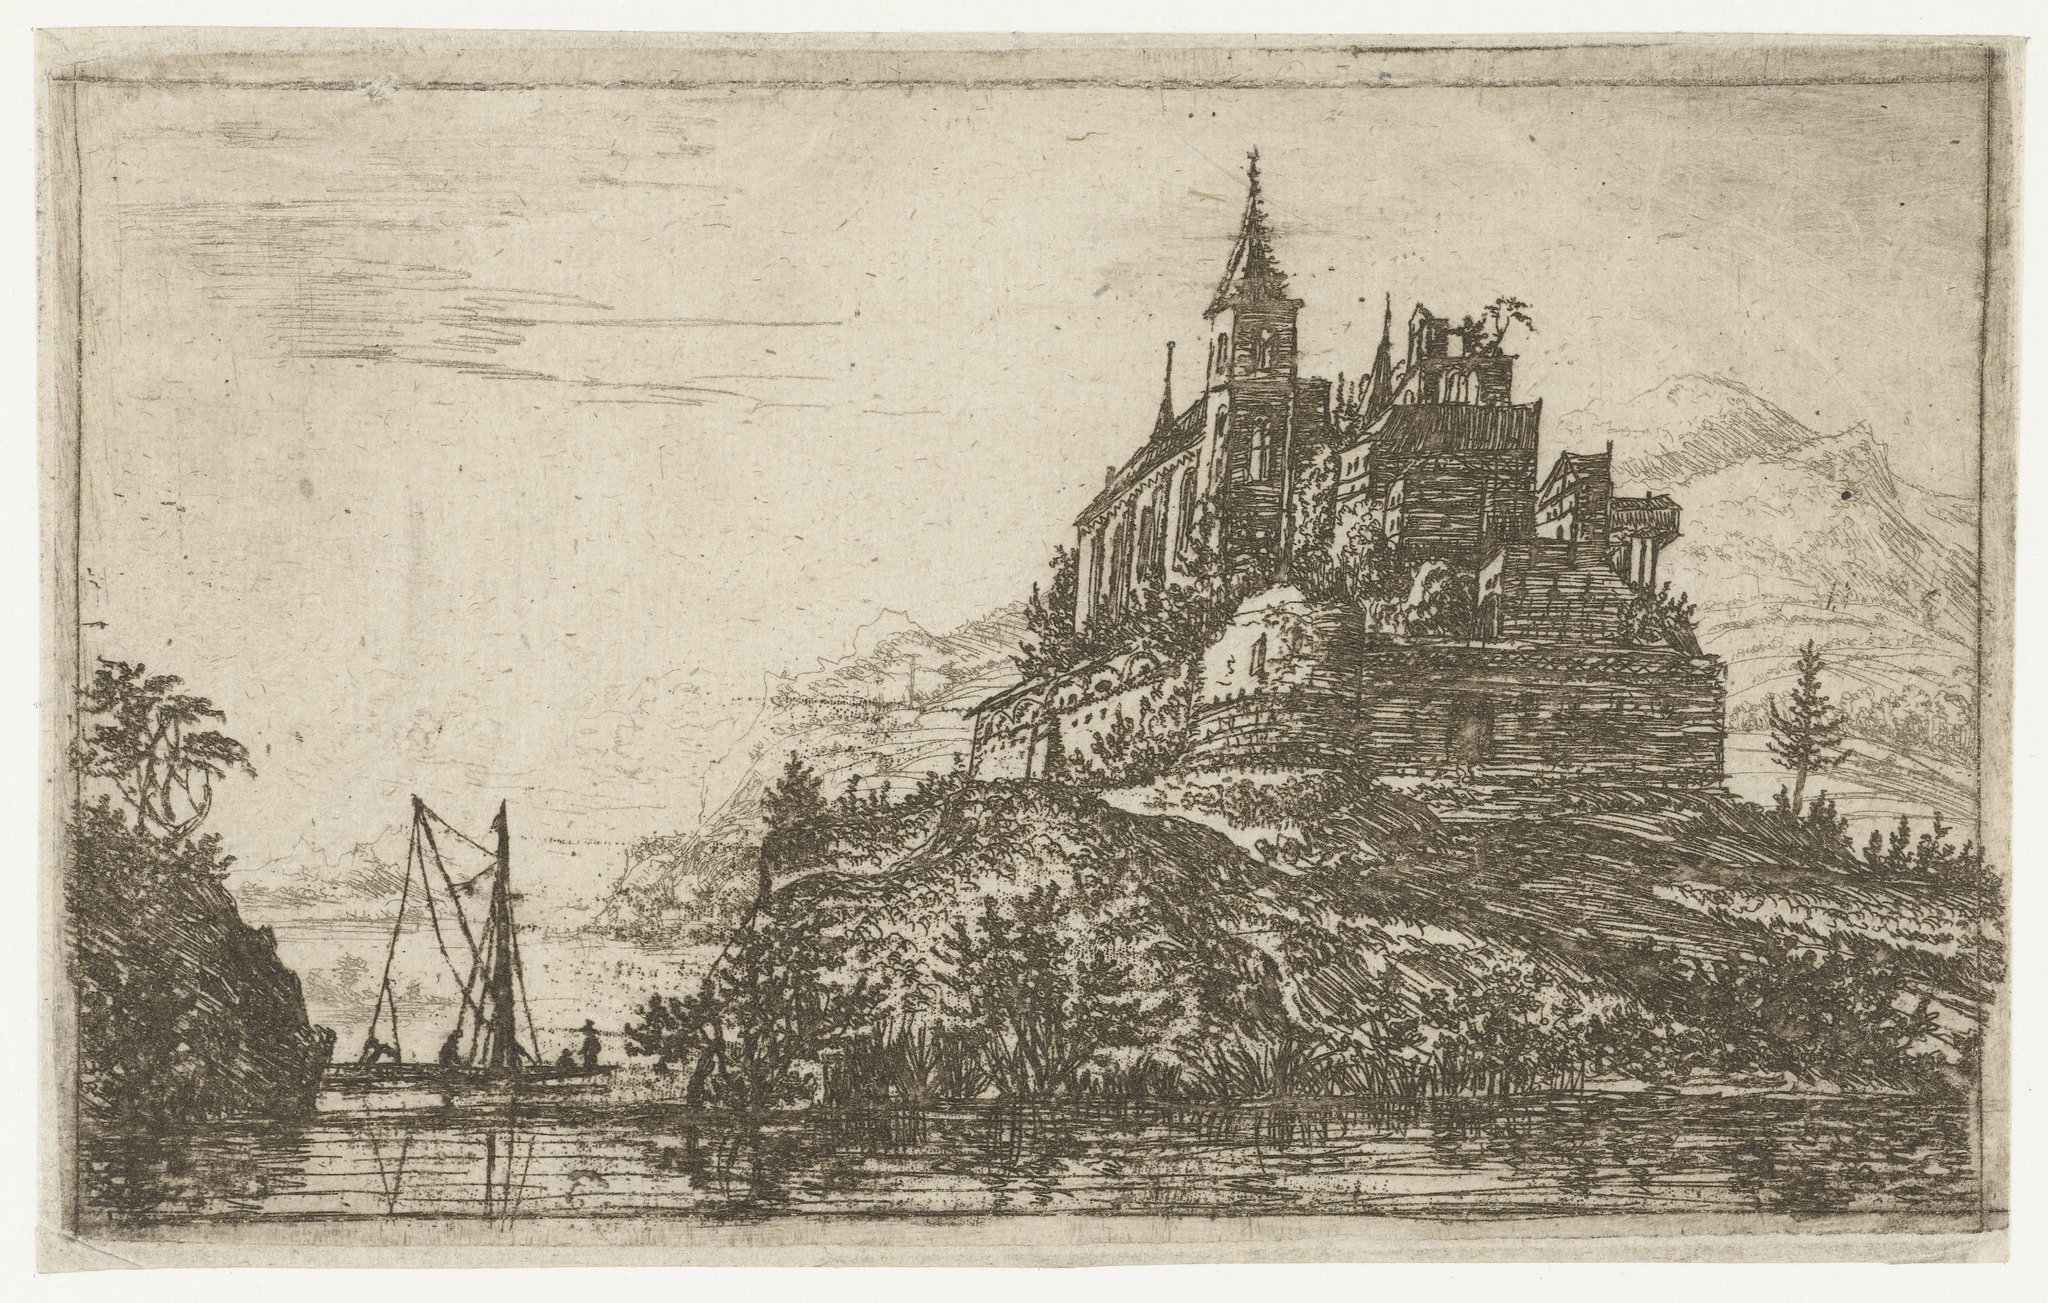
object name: print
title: Landschap met een rivier en een kasteel op een heuvel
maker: jan ruyscher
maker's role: draughtsman, print maker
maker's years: 1625-1674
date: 1635-1674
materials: paper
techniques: etching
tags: castle, river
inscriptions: collector's mark: Lugt 240